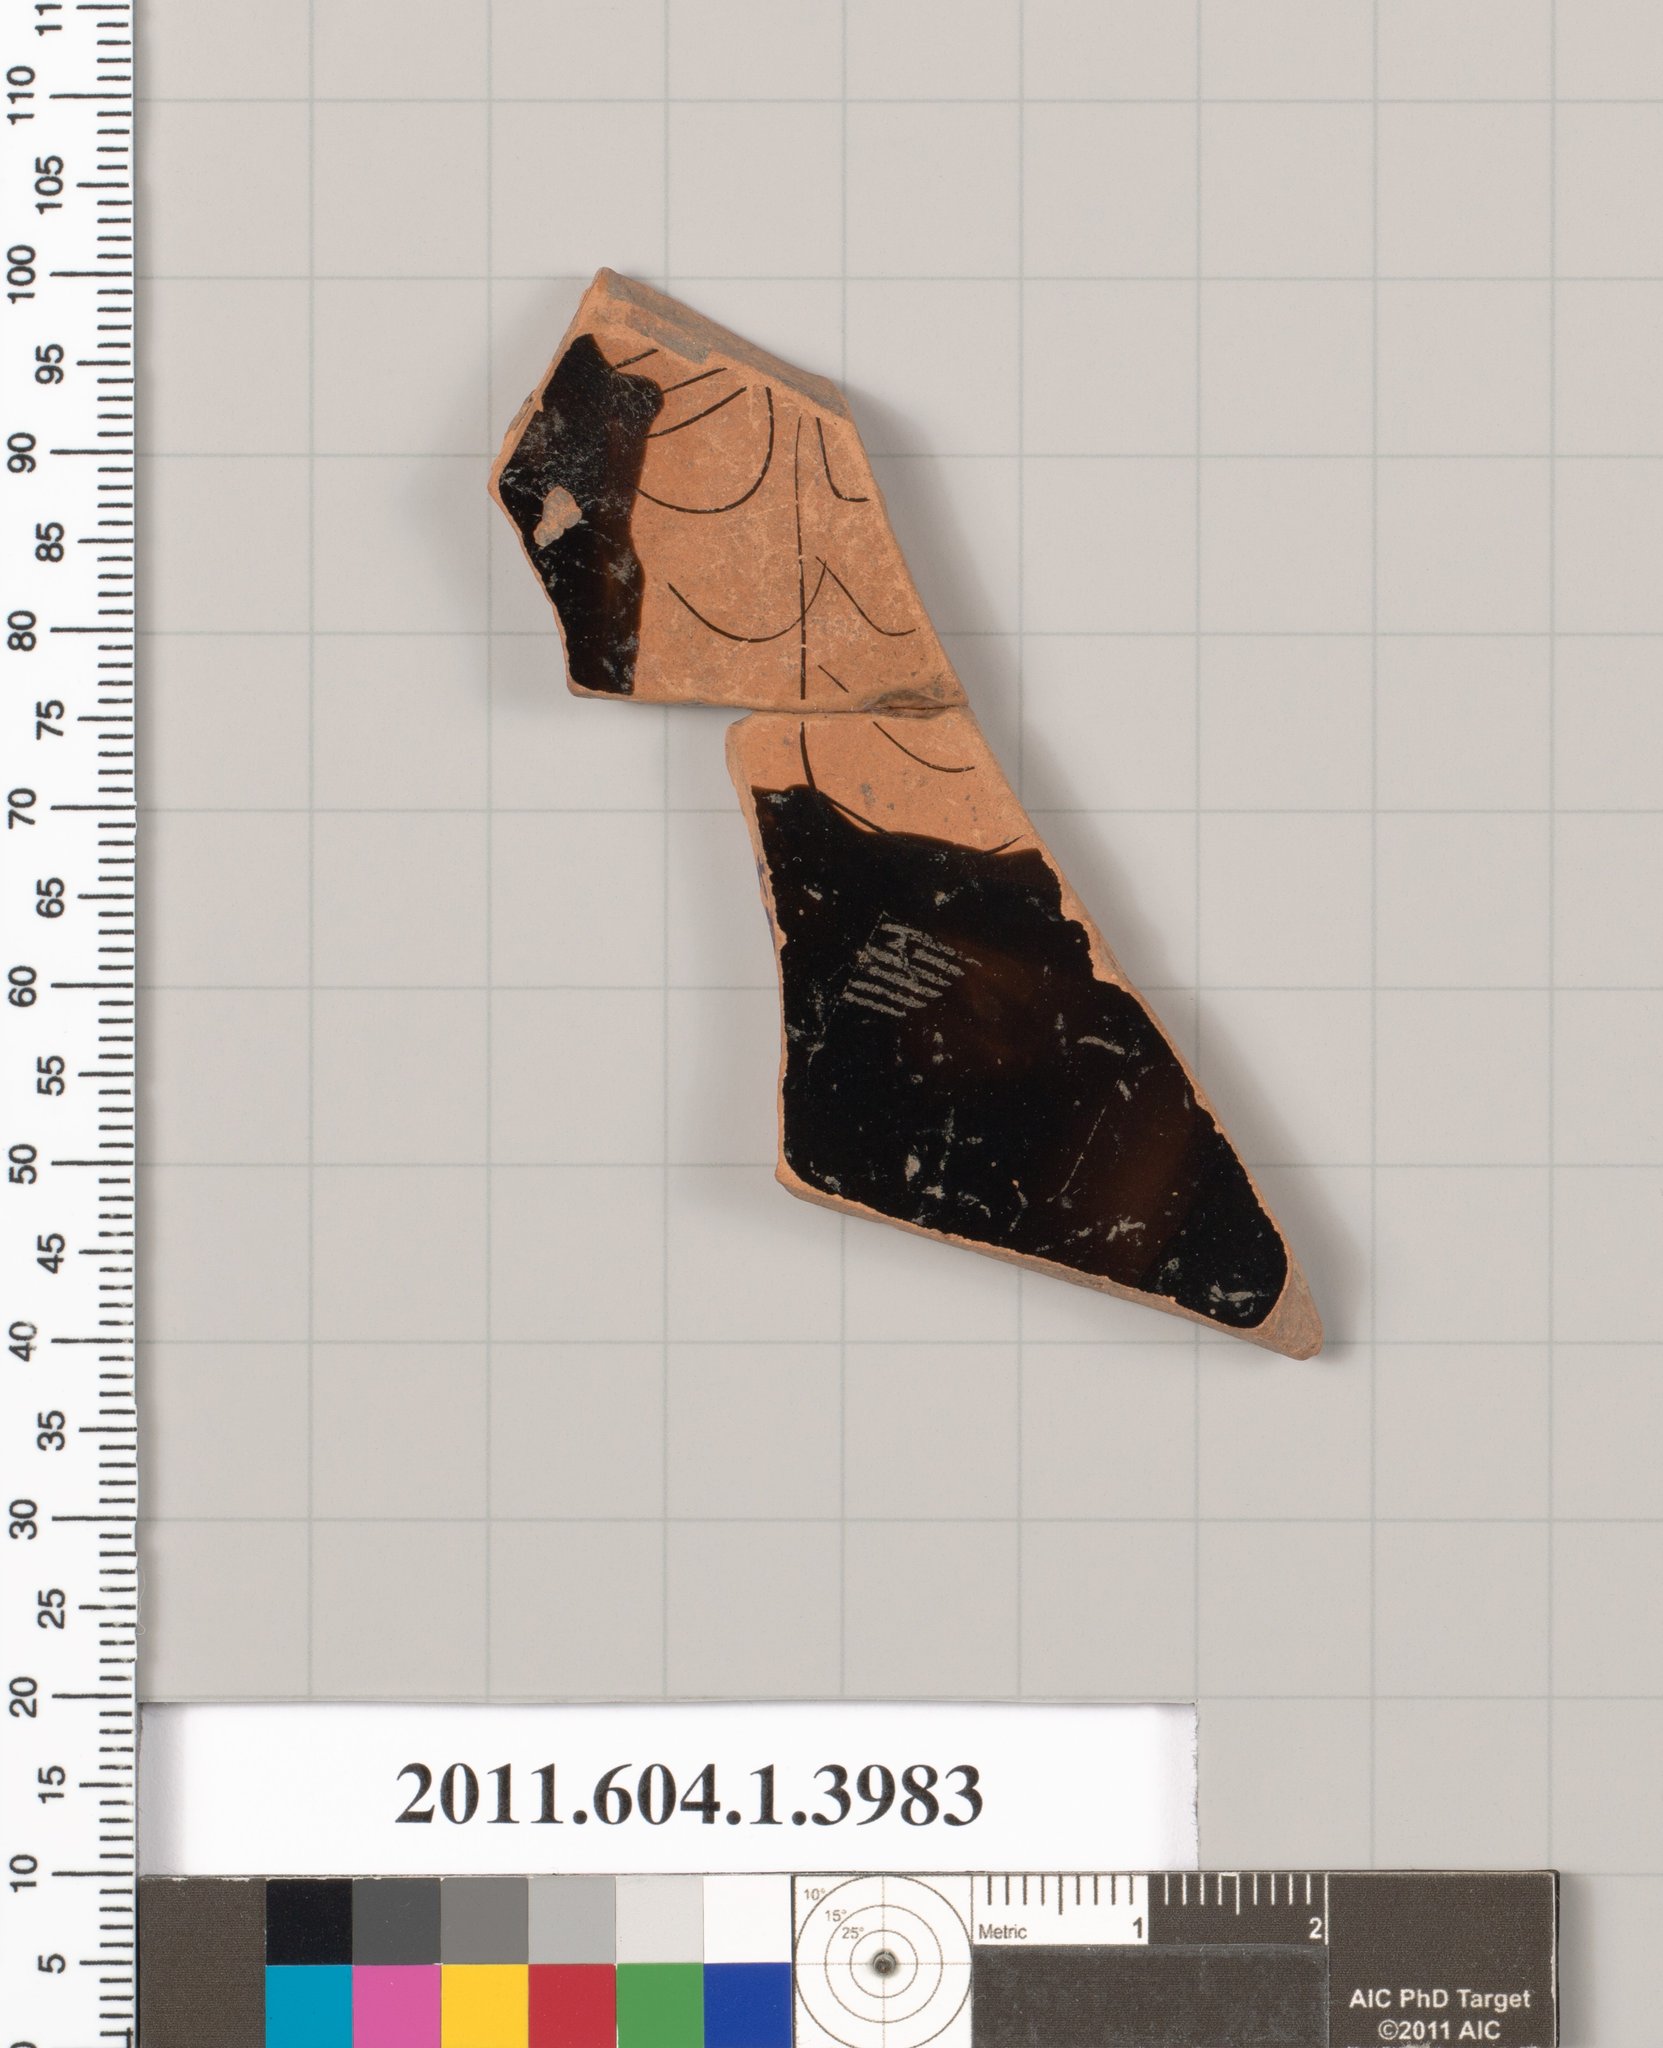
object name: kylix fragment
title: Terracotta fragment of a kylix (drinking cup)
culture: greek, attic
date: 475-451 BCE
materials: terracotta